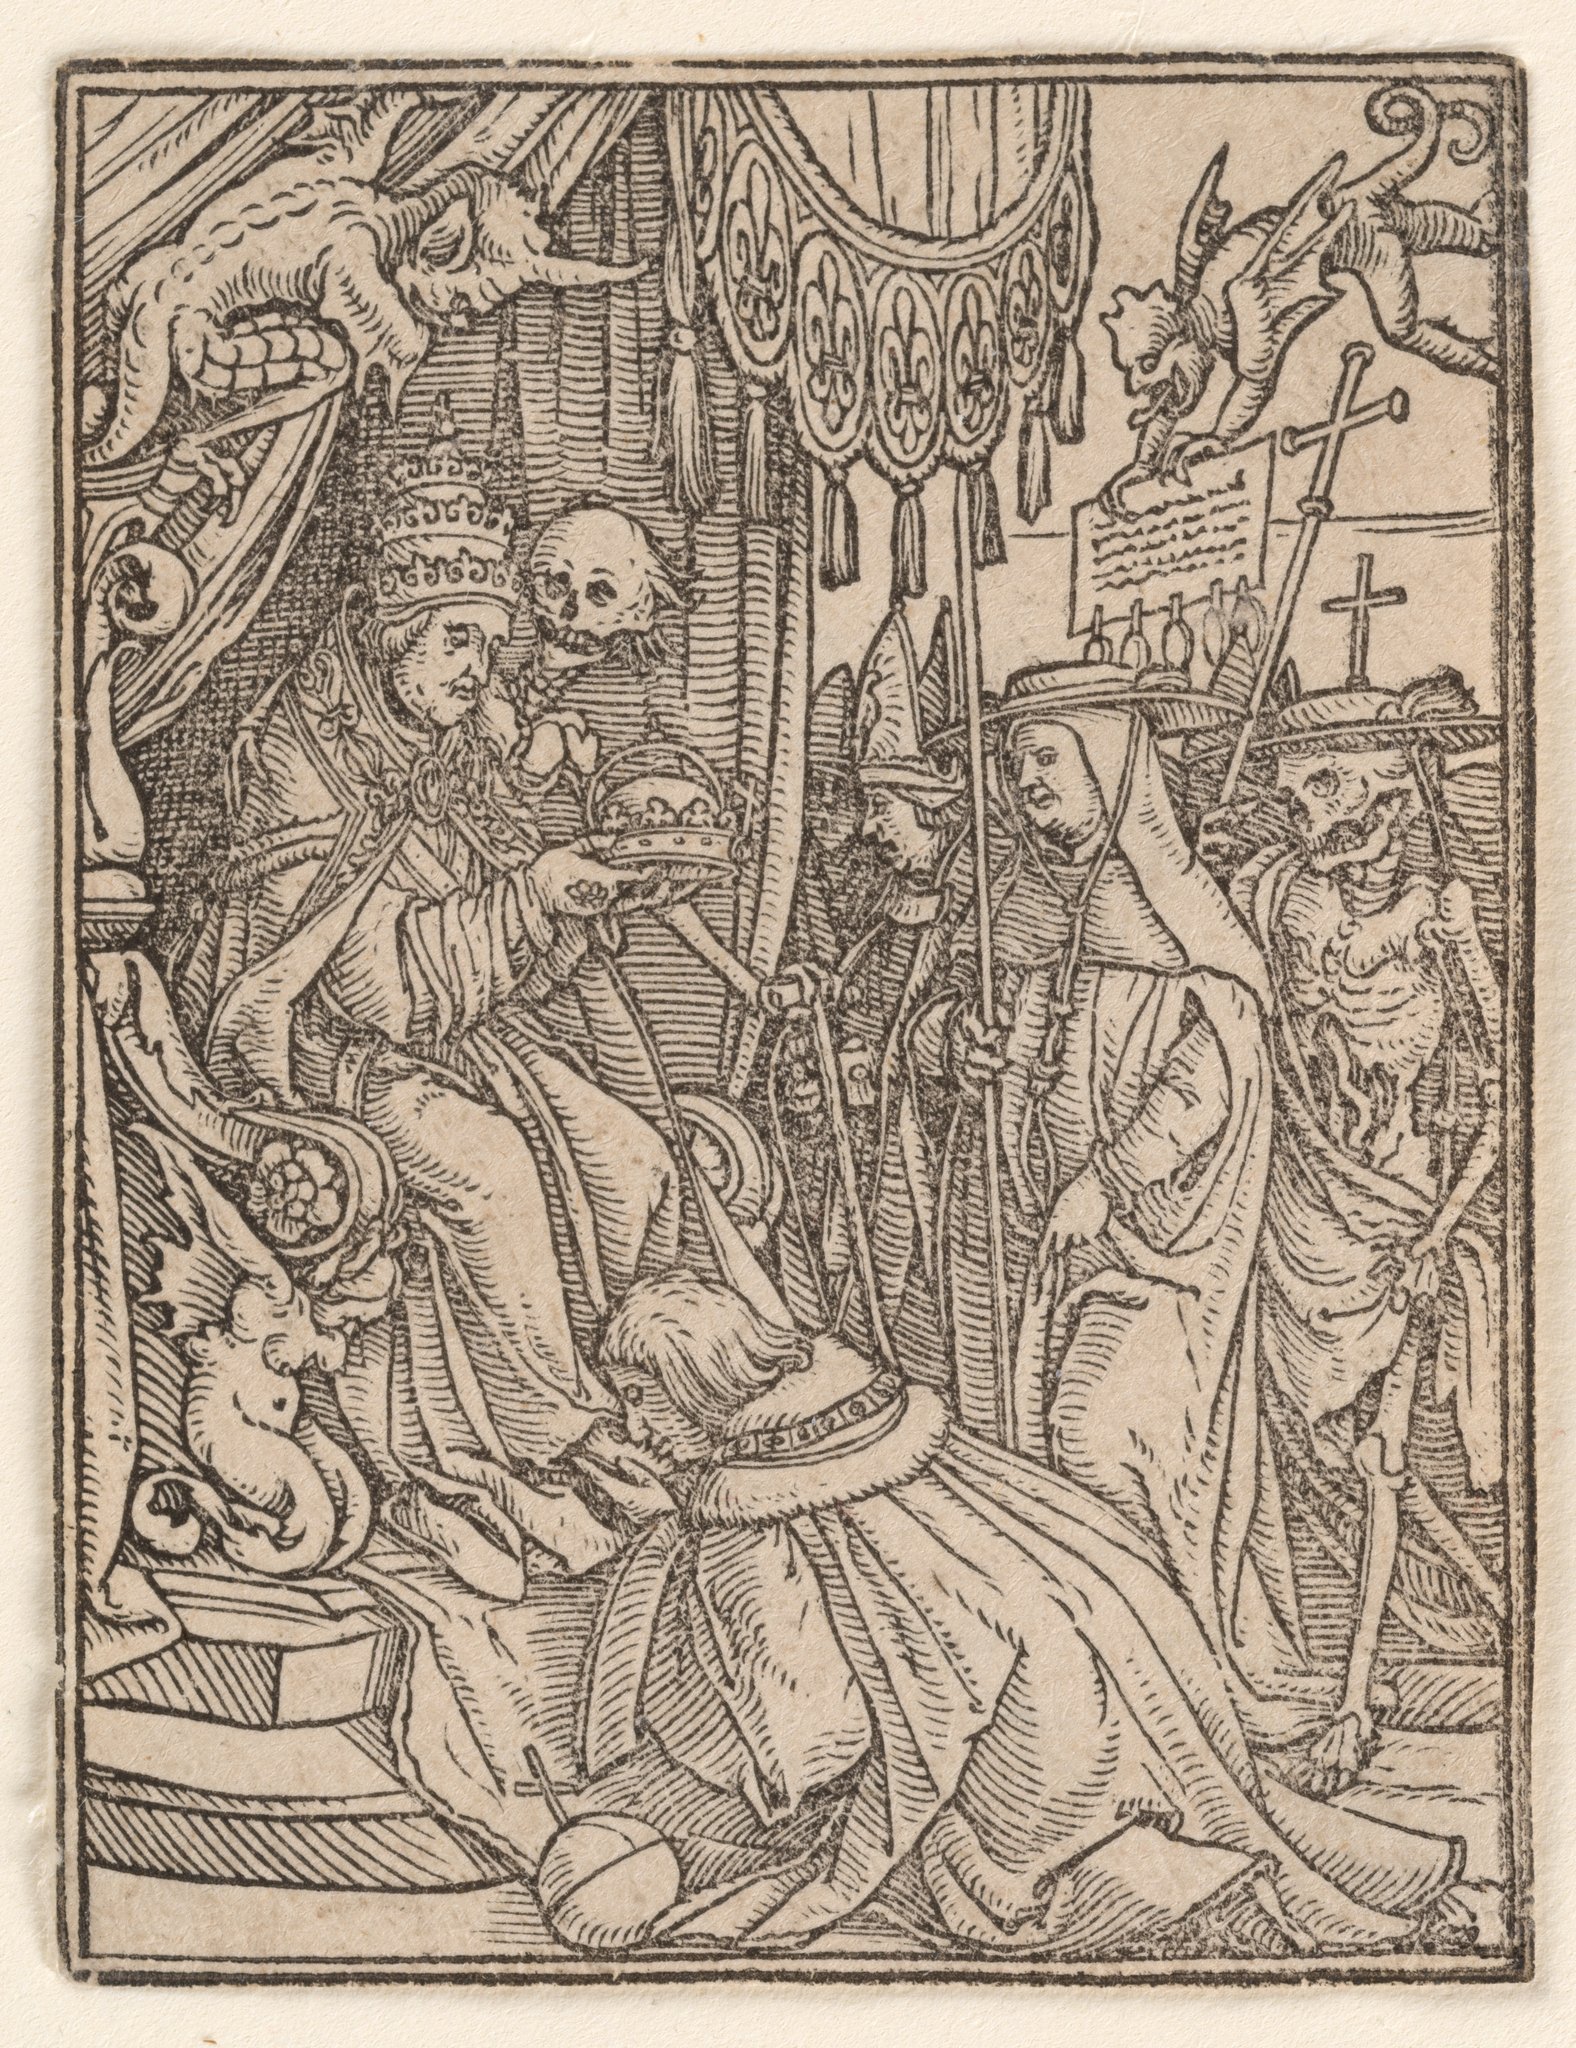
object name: print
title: The Pope, from "The Dance of Death"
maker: hans holbein the younger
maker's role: artist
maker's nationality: german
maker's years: 1497-1543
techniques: woodcut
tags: skeletons,men,popes,crowns